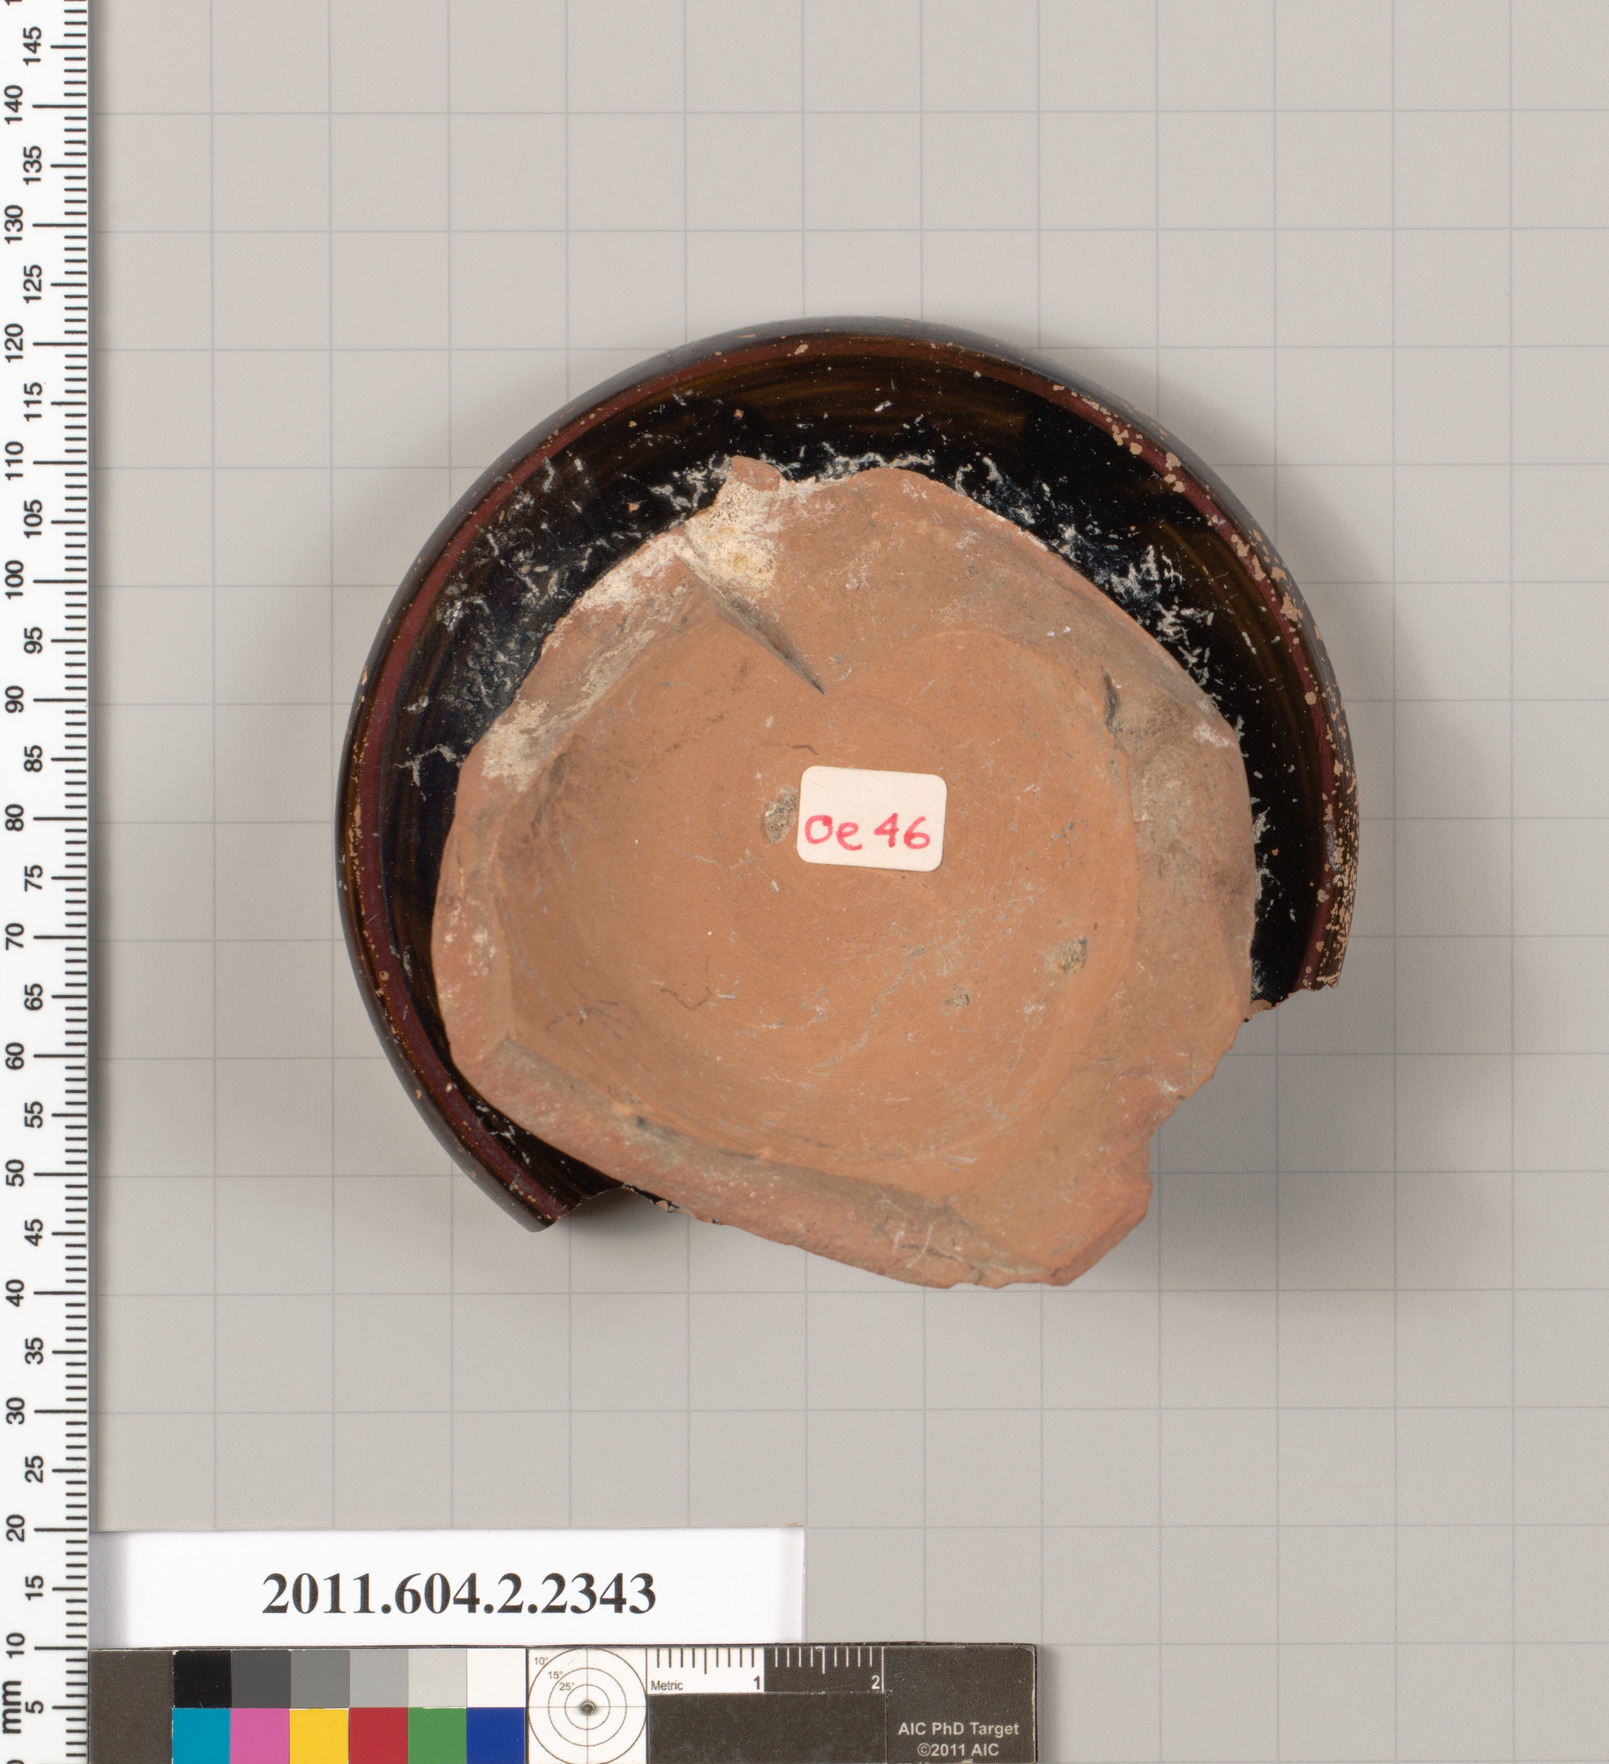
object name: oinochoe fragment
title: Terracotta fragment of an oinochoe (jug)?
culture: greek, attic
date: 600-401 BCE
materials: terracotta